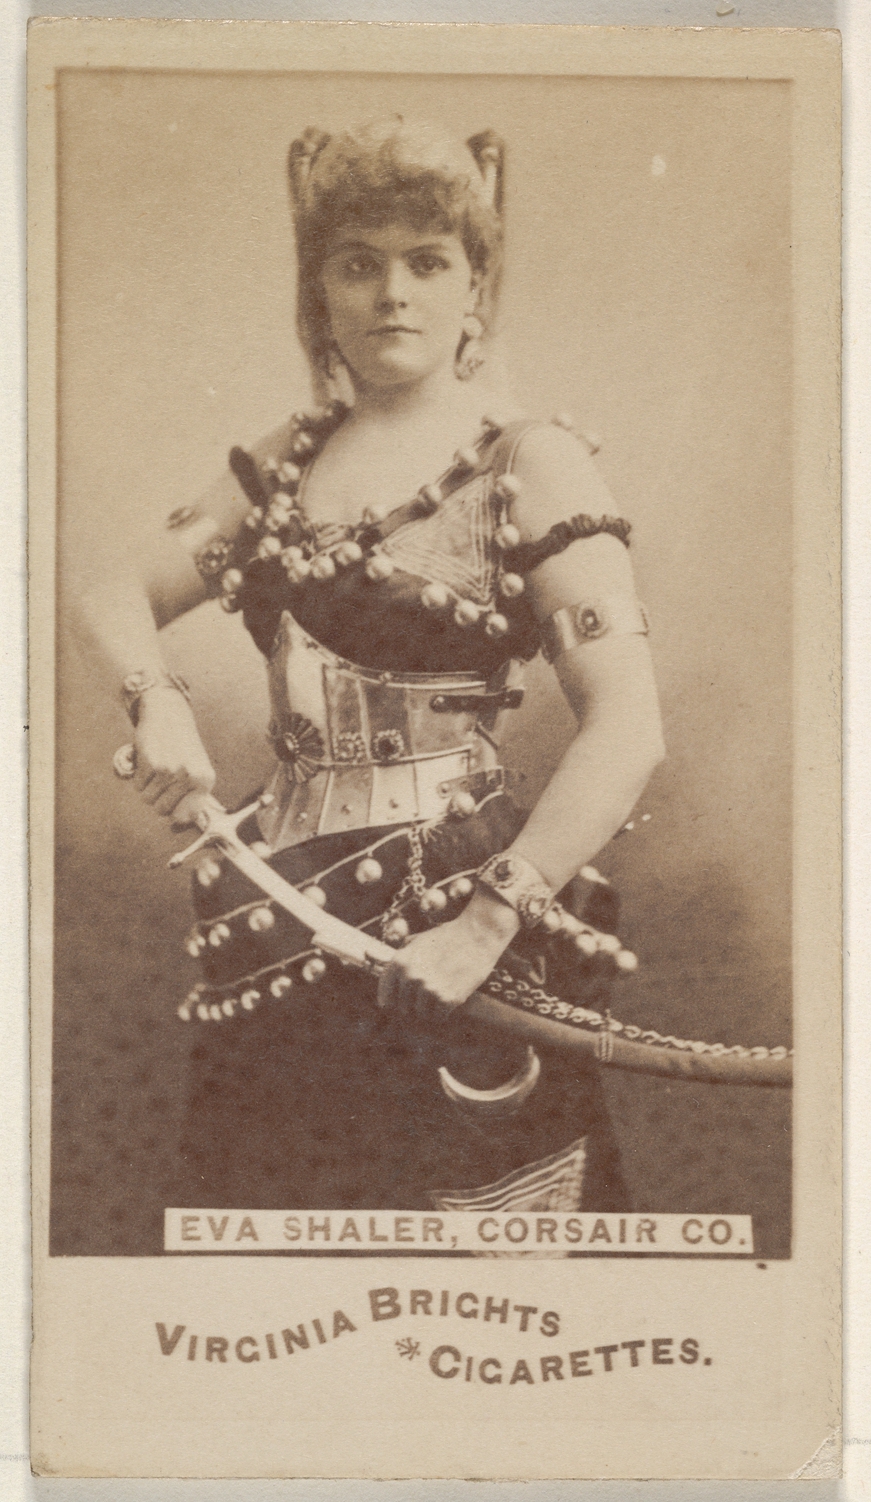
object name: photograph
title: Eva Shaler, Corsair Co., from the Actors and Actresses series (N45, Type 6) for Virginia Brights Cigarettes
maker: allen & ginter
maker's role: publisher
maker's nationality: american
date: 1888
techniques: albumen silver print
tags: swords,portraits,women,actresses